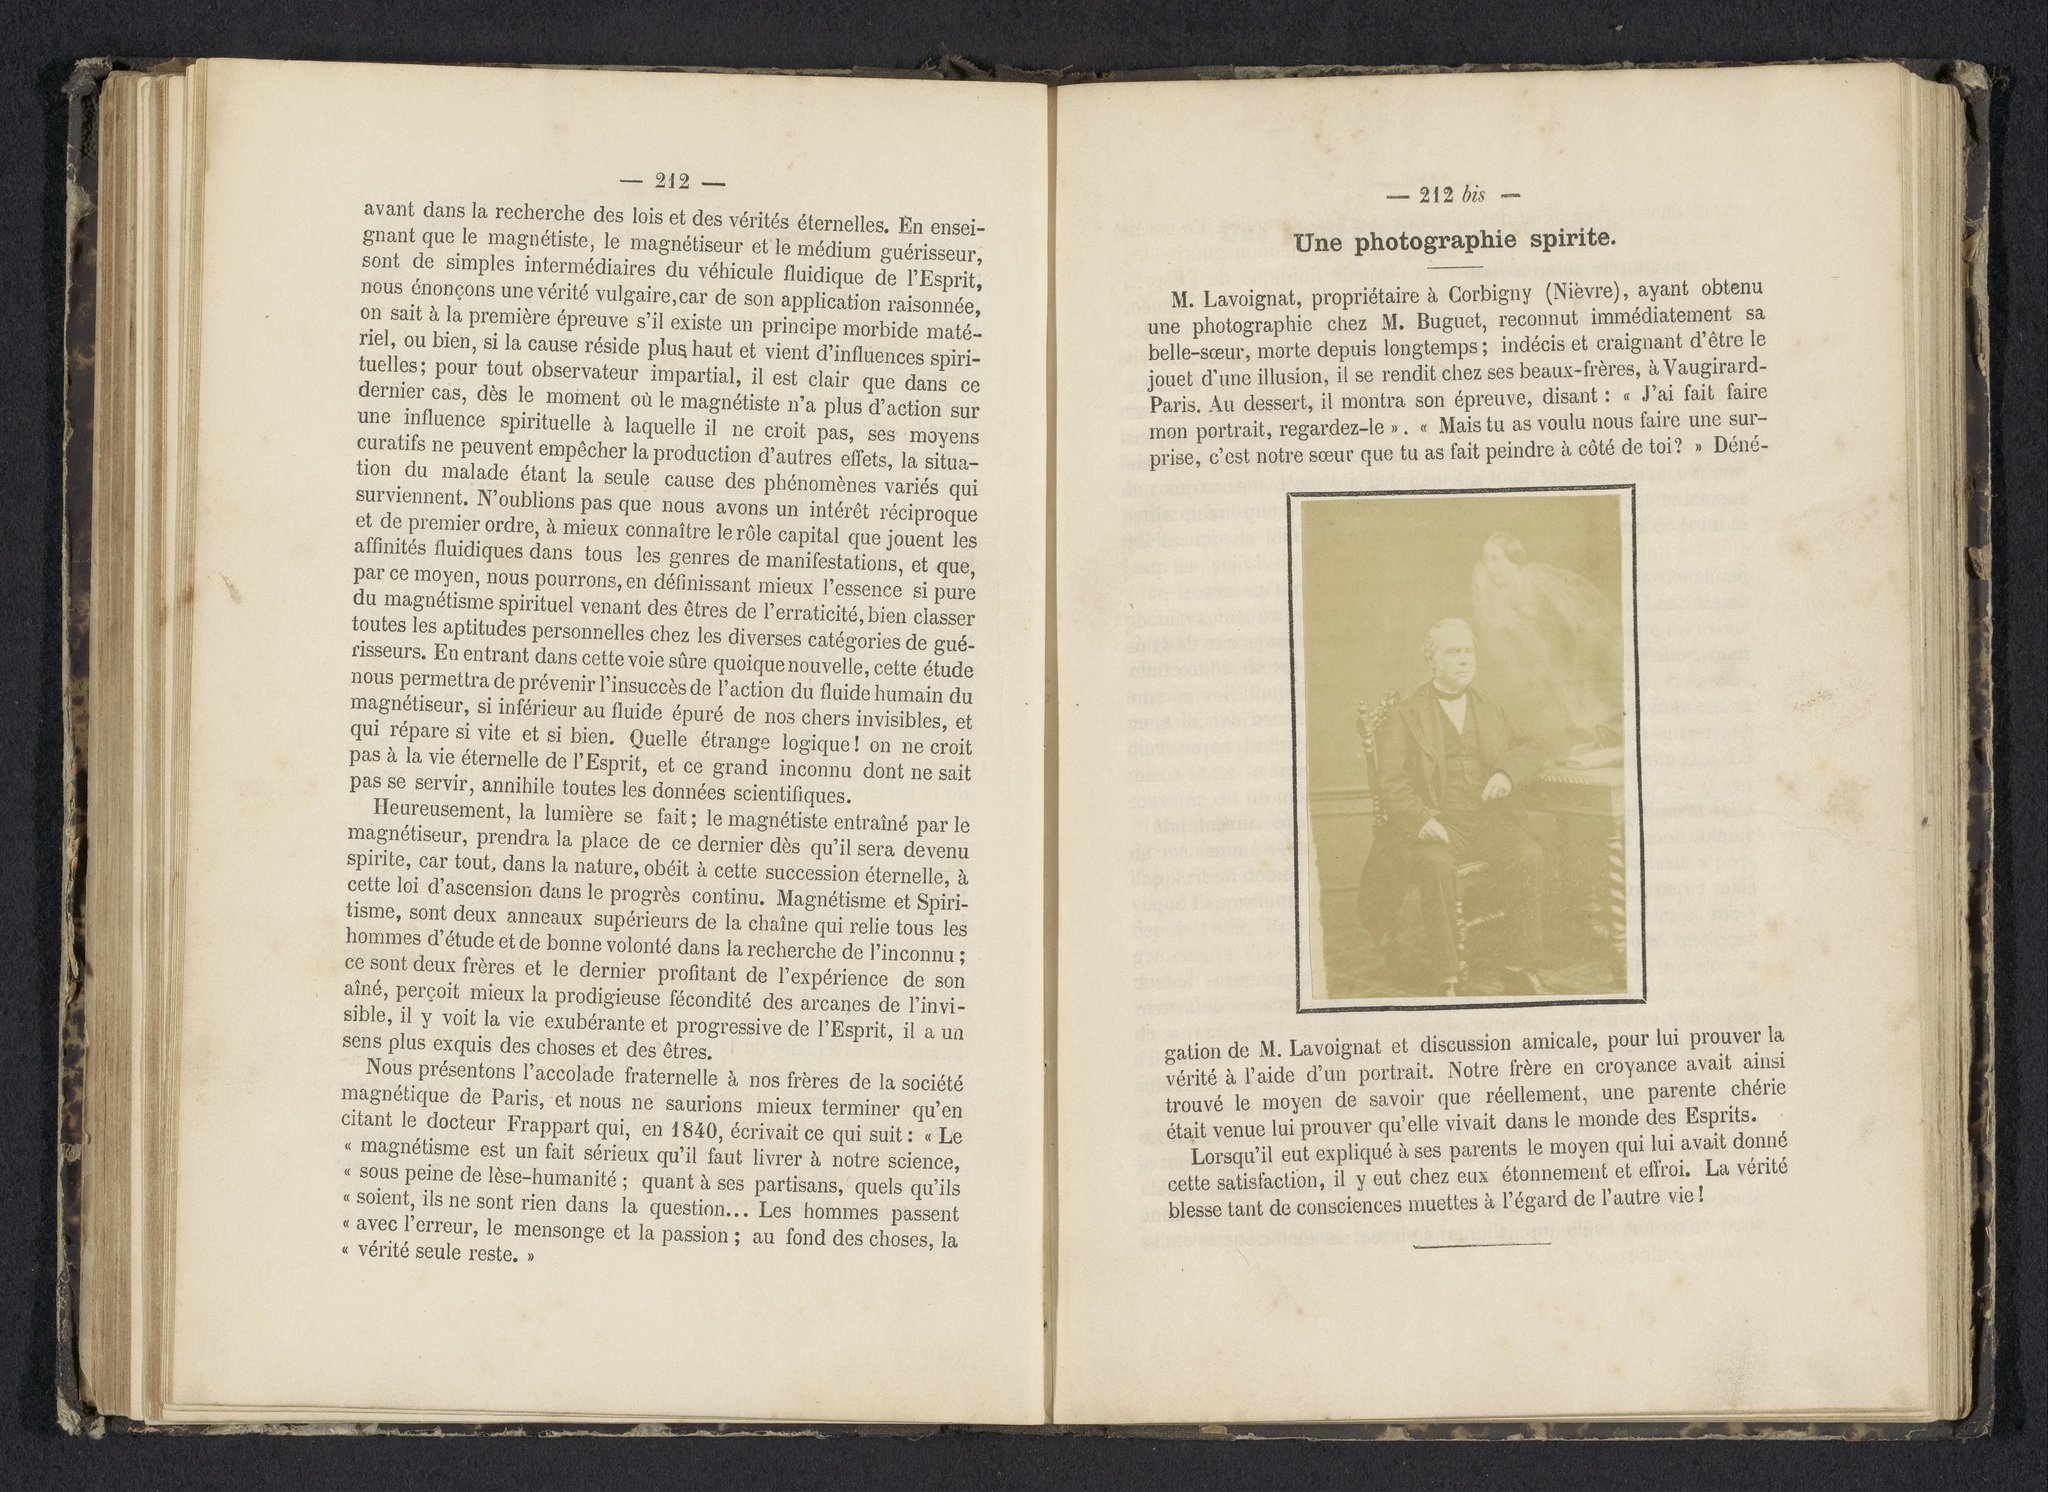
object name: photograph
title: Portret van de heer Lavoignat en de geest van zijn schoonzus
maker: édouard isidore buguet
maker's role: fotograaf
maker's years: 1840-1901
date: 1869-1874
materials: photographic support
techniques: albumen print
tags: historical persons, materialization, appearance of spirit or ghost